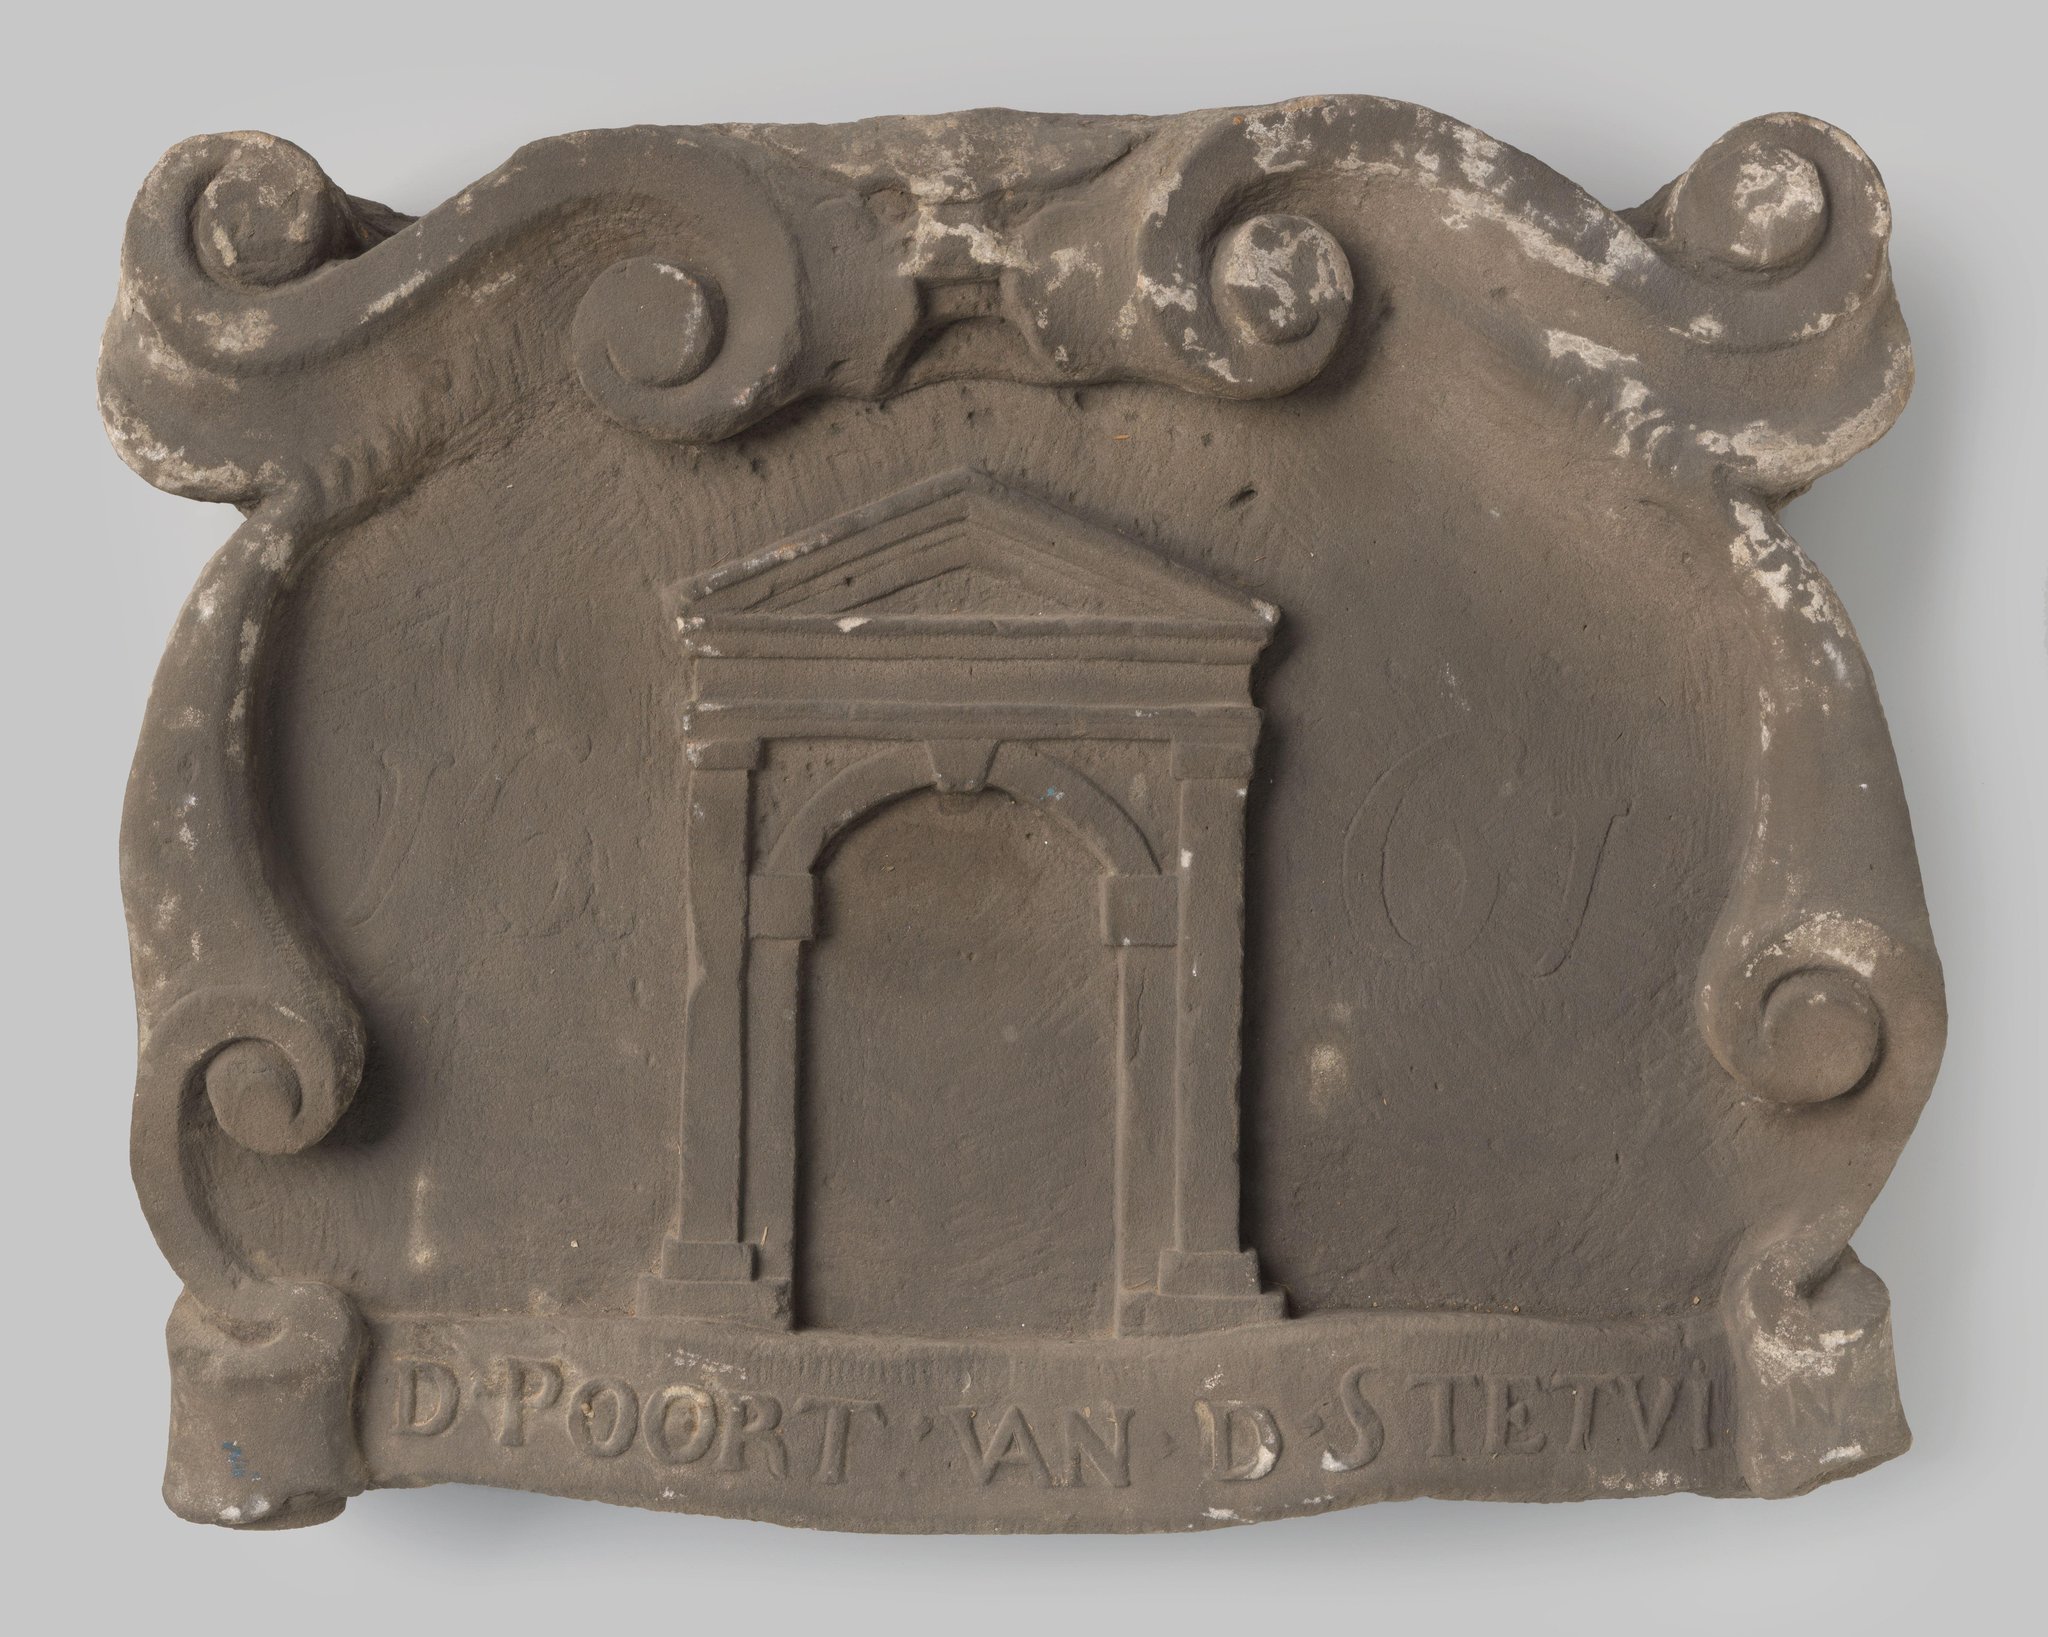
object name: gable stone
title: Gevelsteen met afbeelding poort met opschrift: D POORT VAN D STETVIN.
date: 1661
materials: stone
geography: netherlands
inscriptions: date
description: Cartouche met boven- en zijkanten in voluutvormen en de onderrand in de vorm van een lint. Binnen het cartouche een afbeelding van een poort waarvan links het getal 16 en rechts het getal 61. Op het lint het opschrift D POORT VAN D STETVIN.